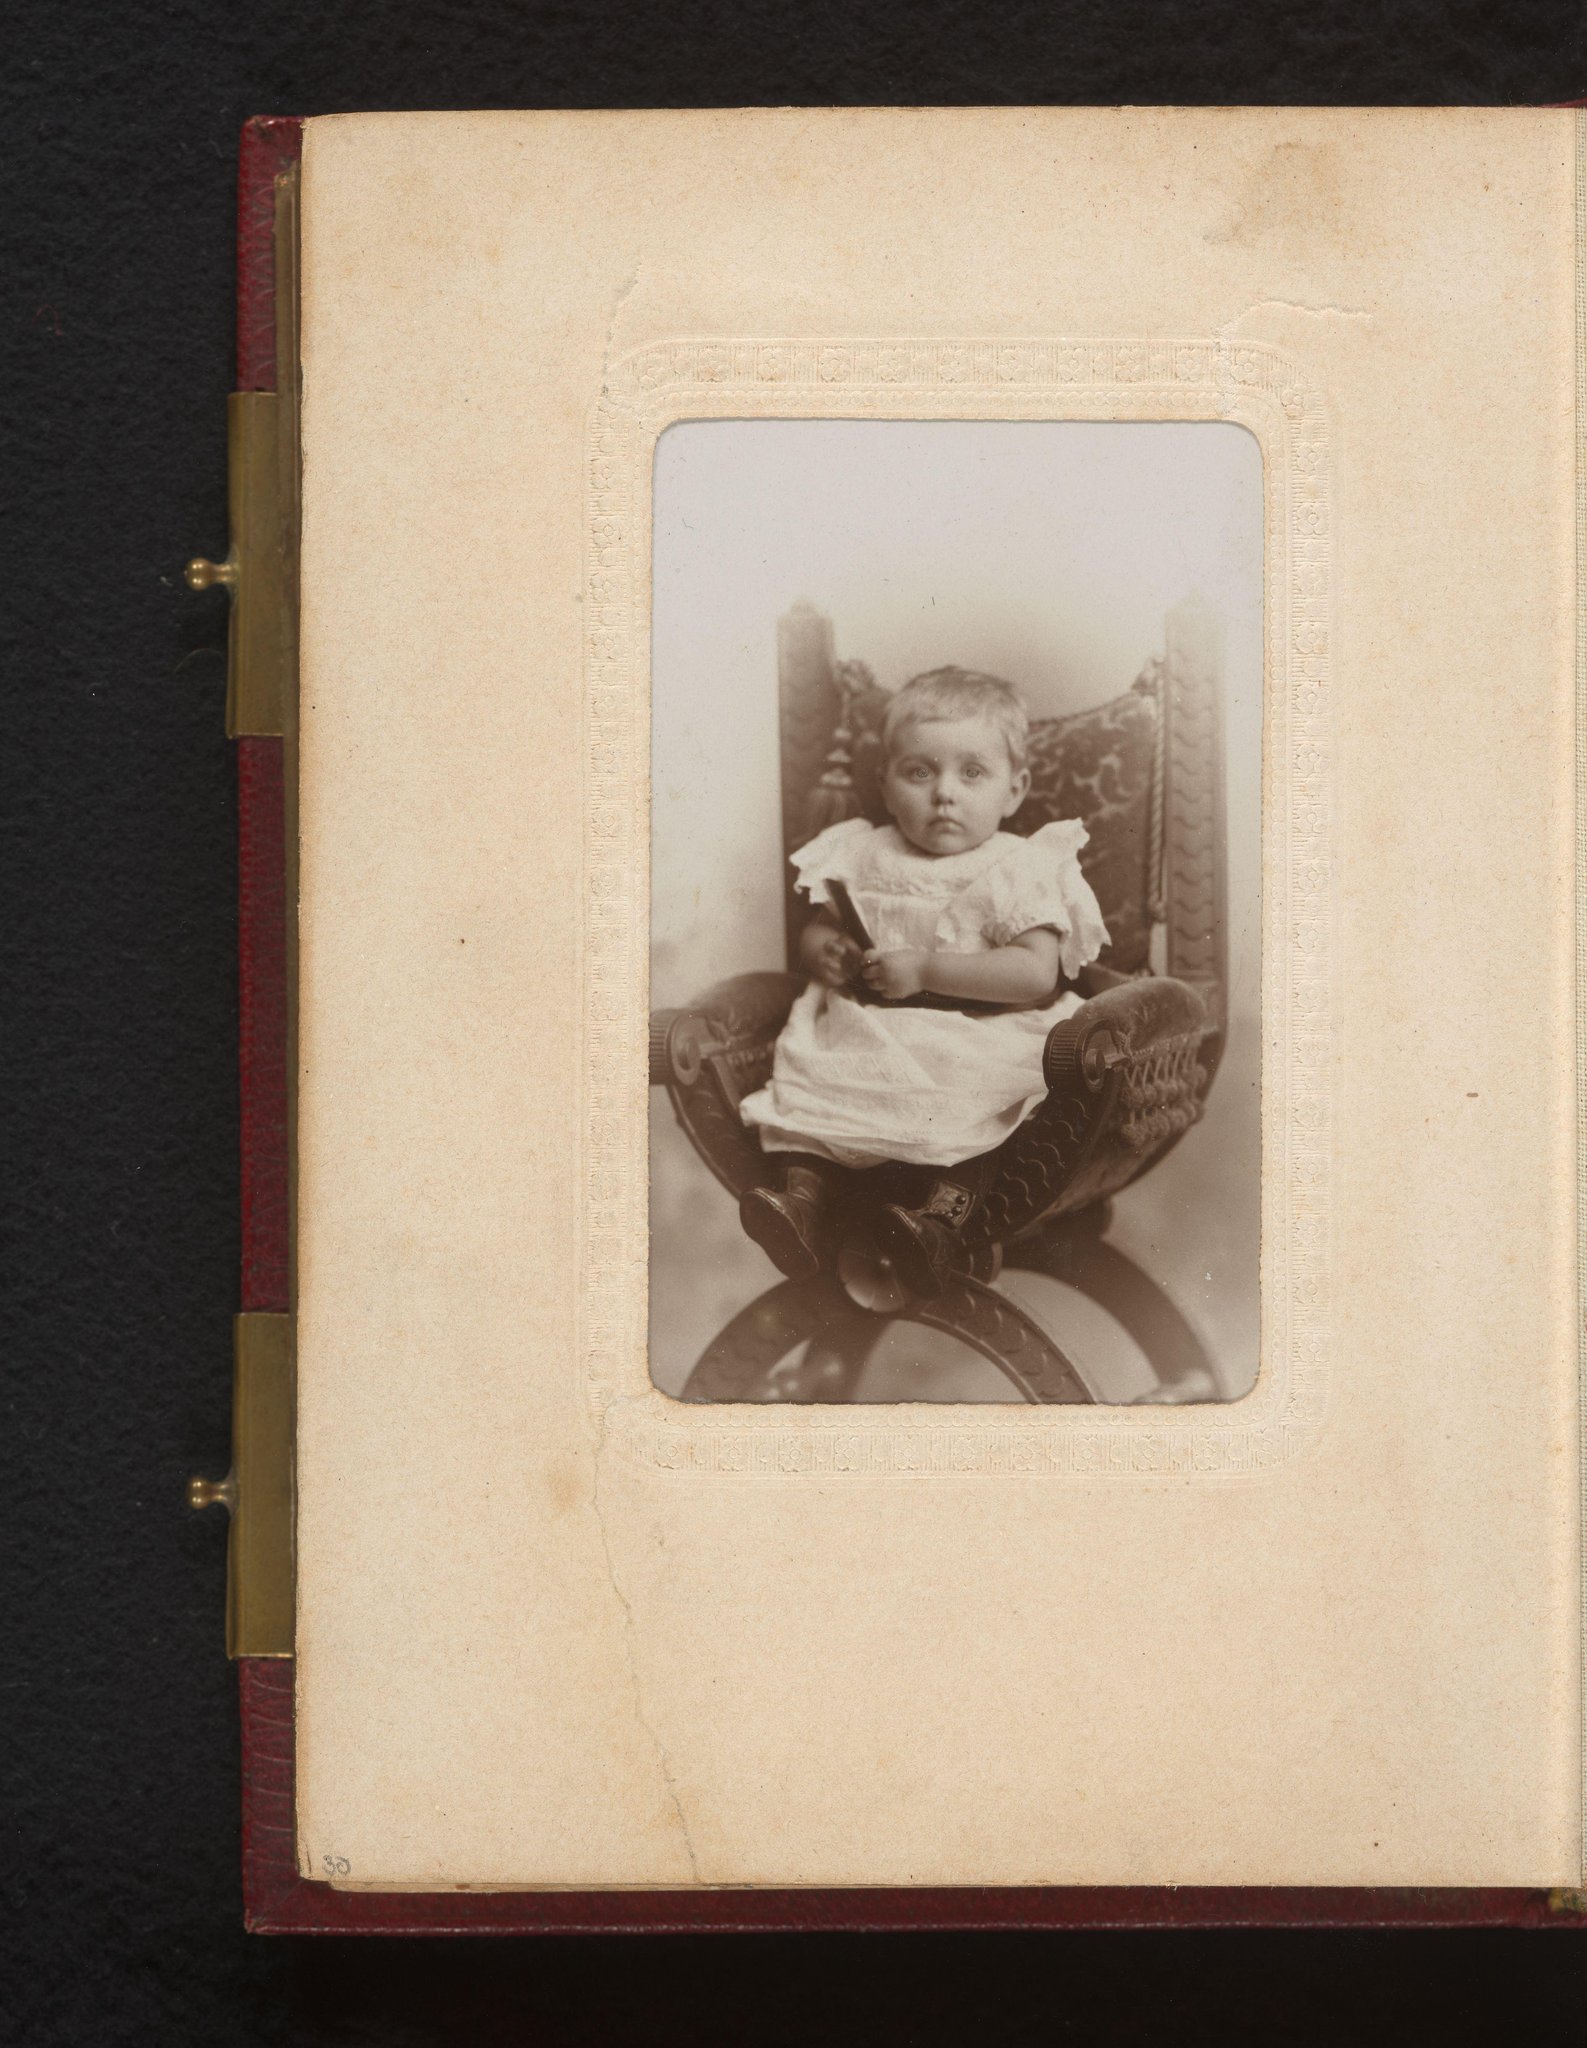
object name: album leaf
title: Portret van een peuter, zittend op een kinderstoel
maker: Anonymous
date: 1880-1920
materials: cardboard, photographic support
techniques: albumen print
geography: netherlands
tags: sitting figure, historical persons, tot, toddler ~ the ages of man